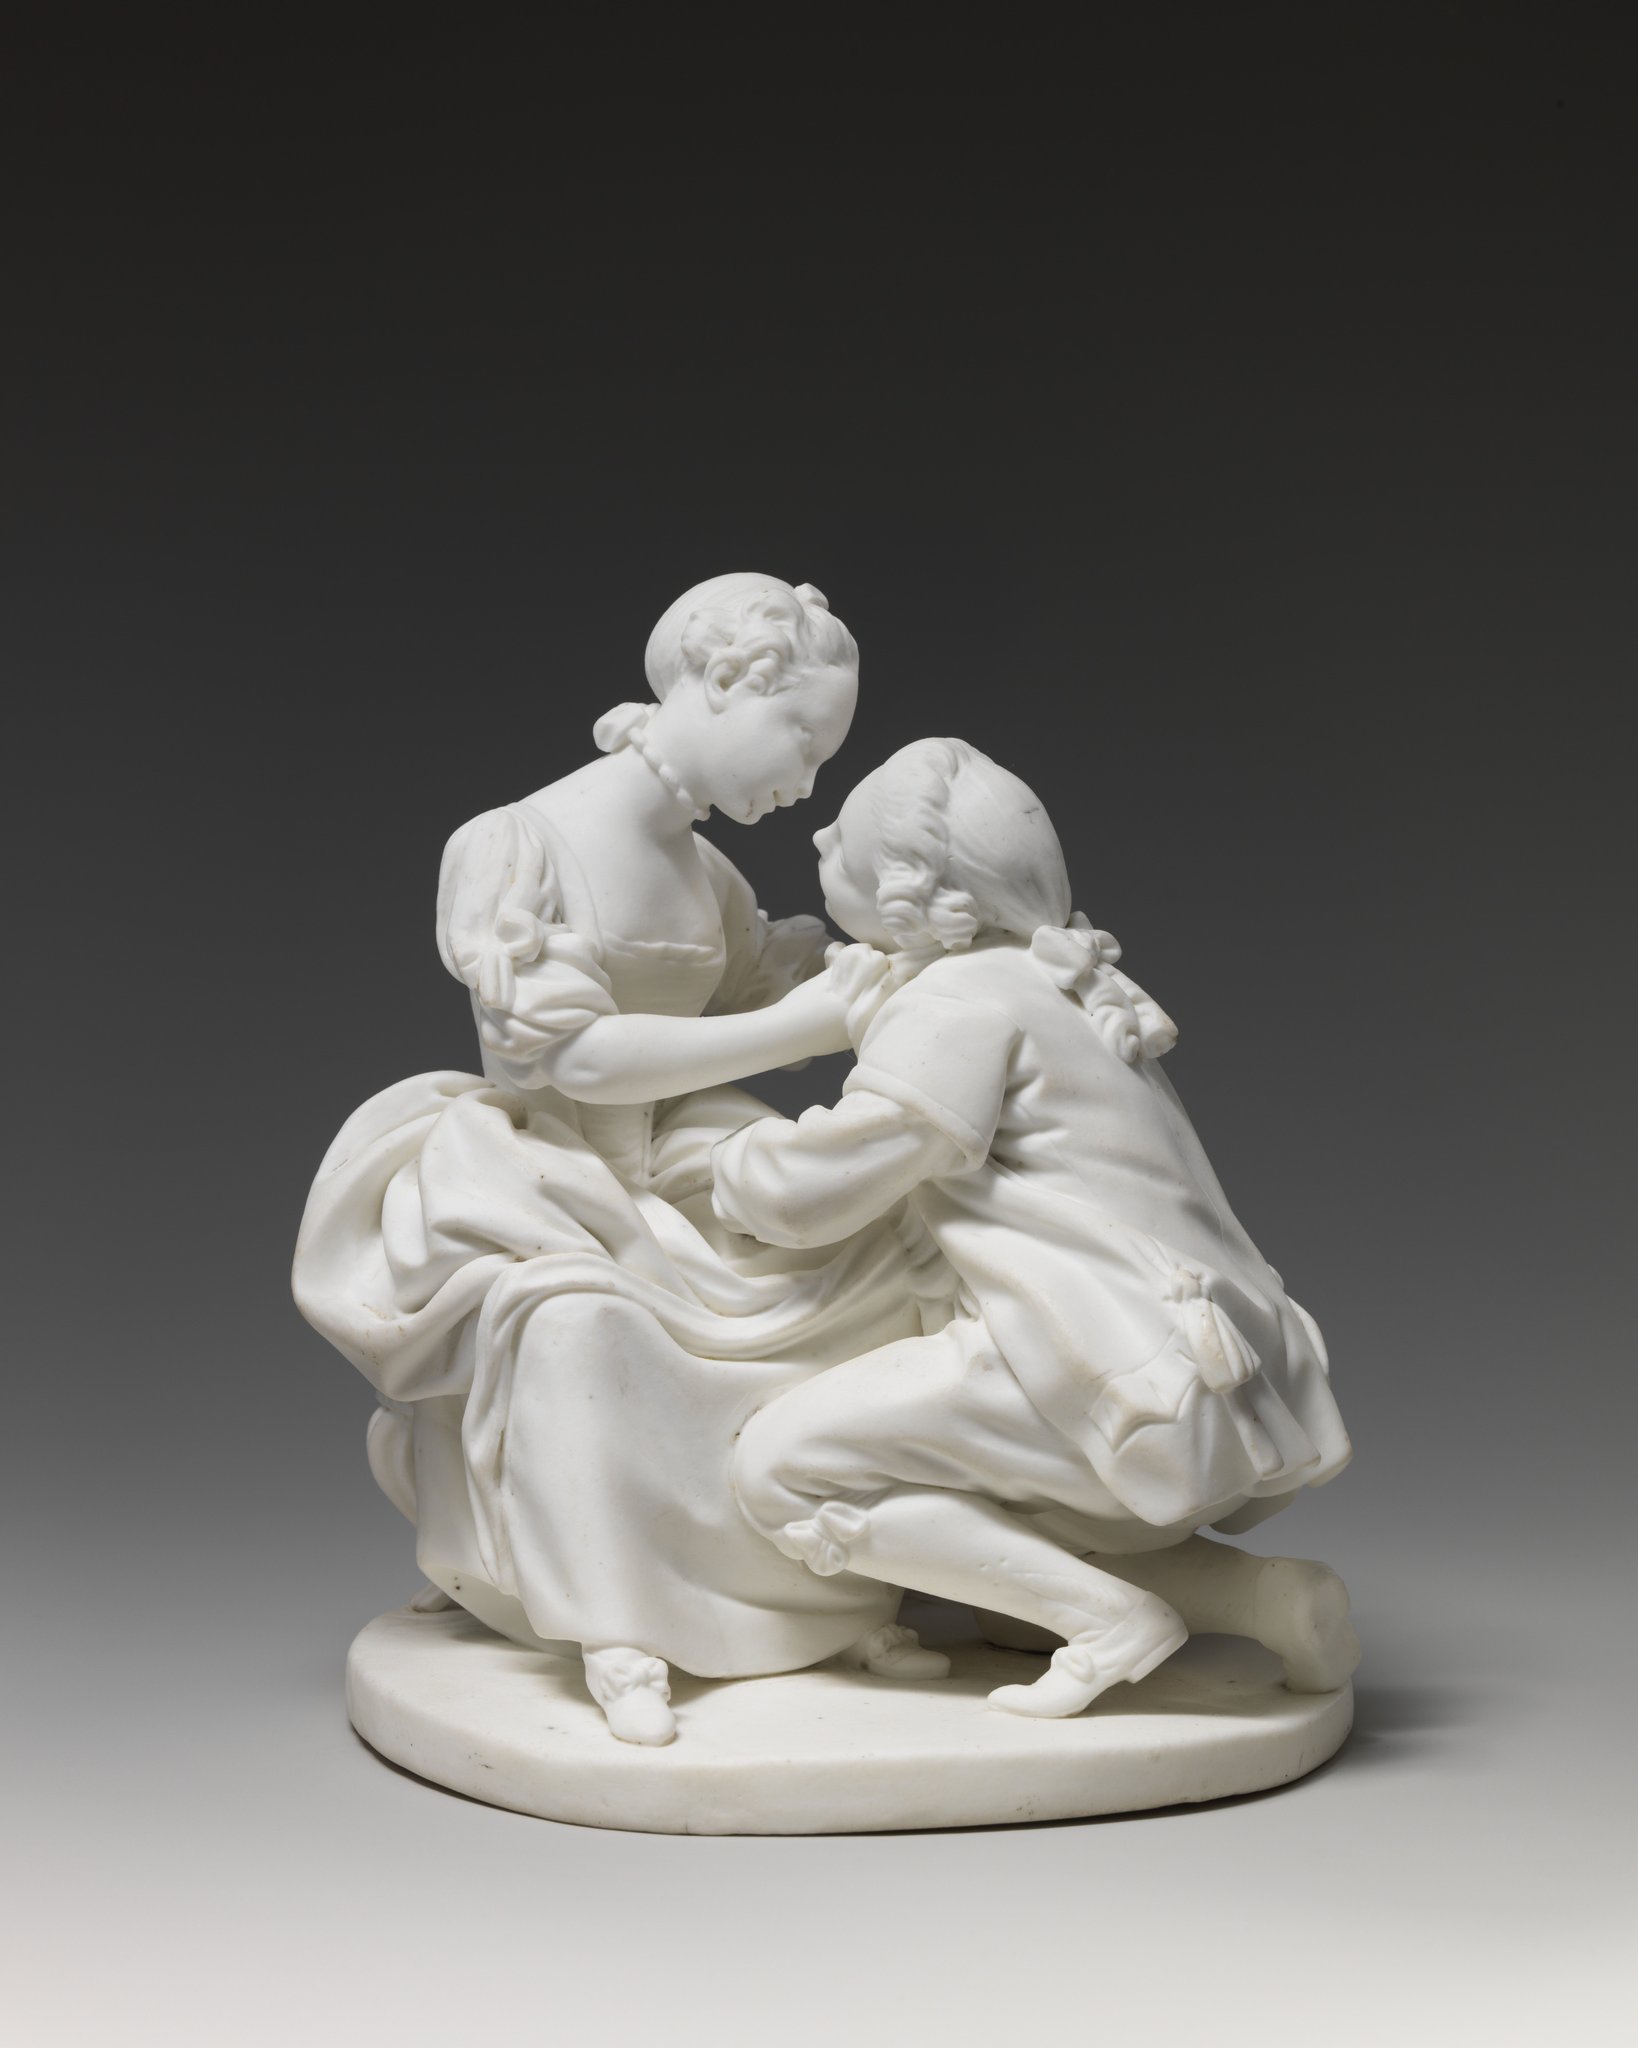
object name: group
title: L'Oracle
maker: sèvres manufactory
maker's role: manufactory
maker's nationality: french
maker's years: 1740-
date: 1766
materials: biscuit, paste, porcelain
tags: men,women